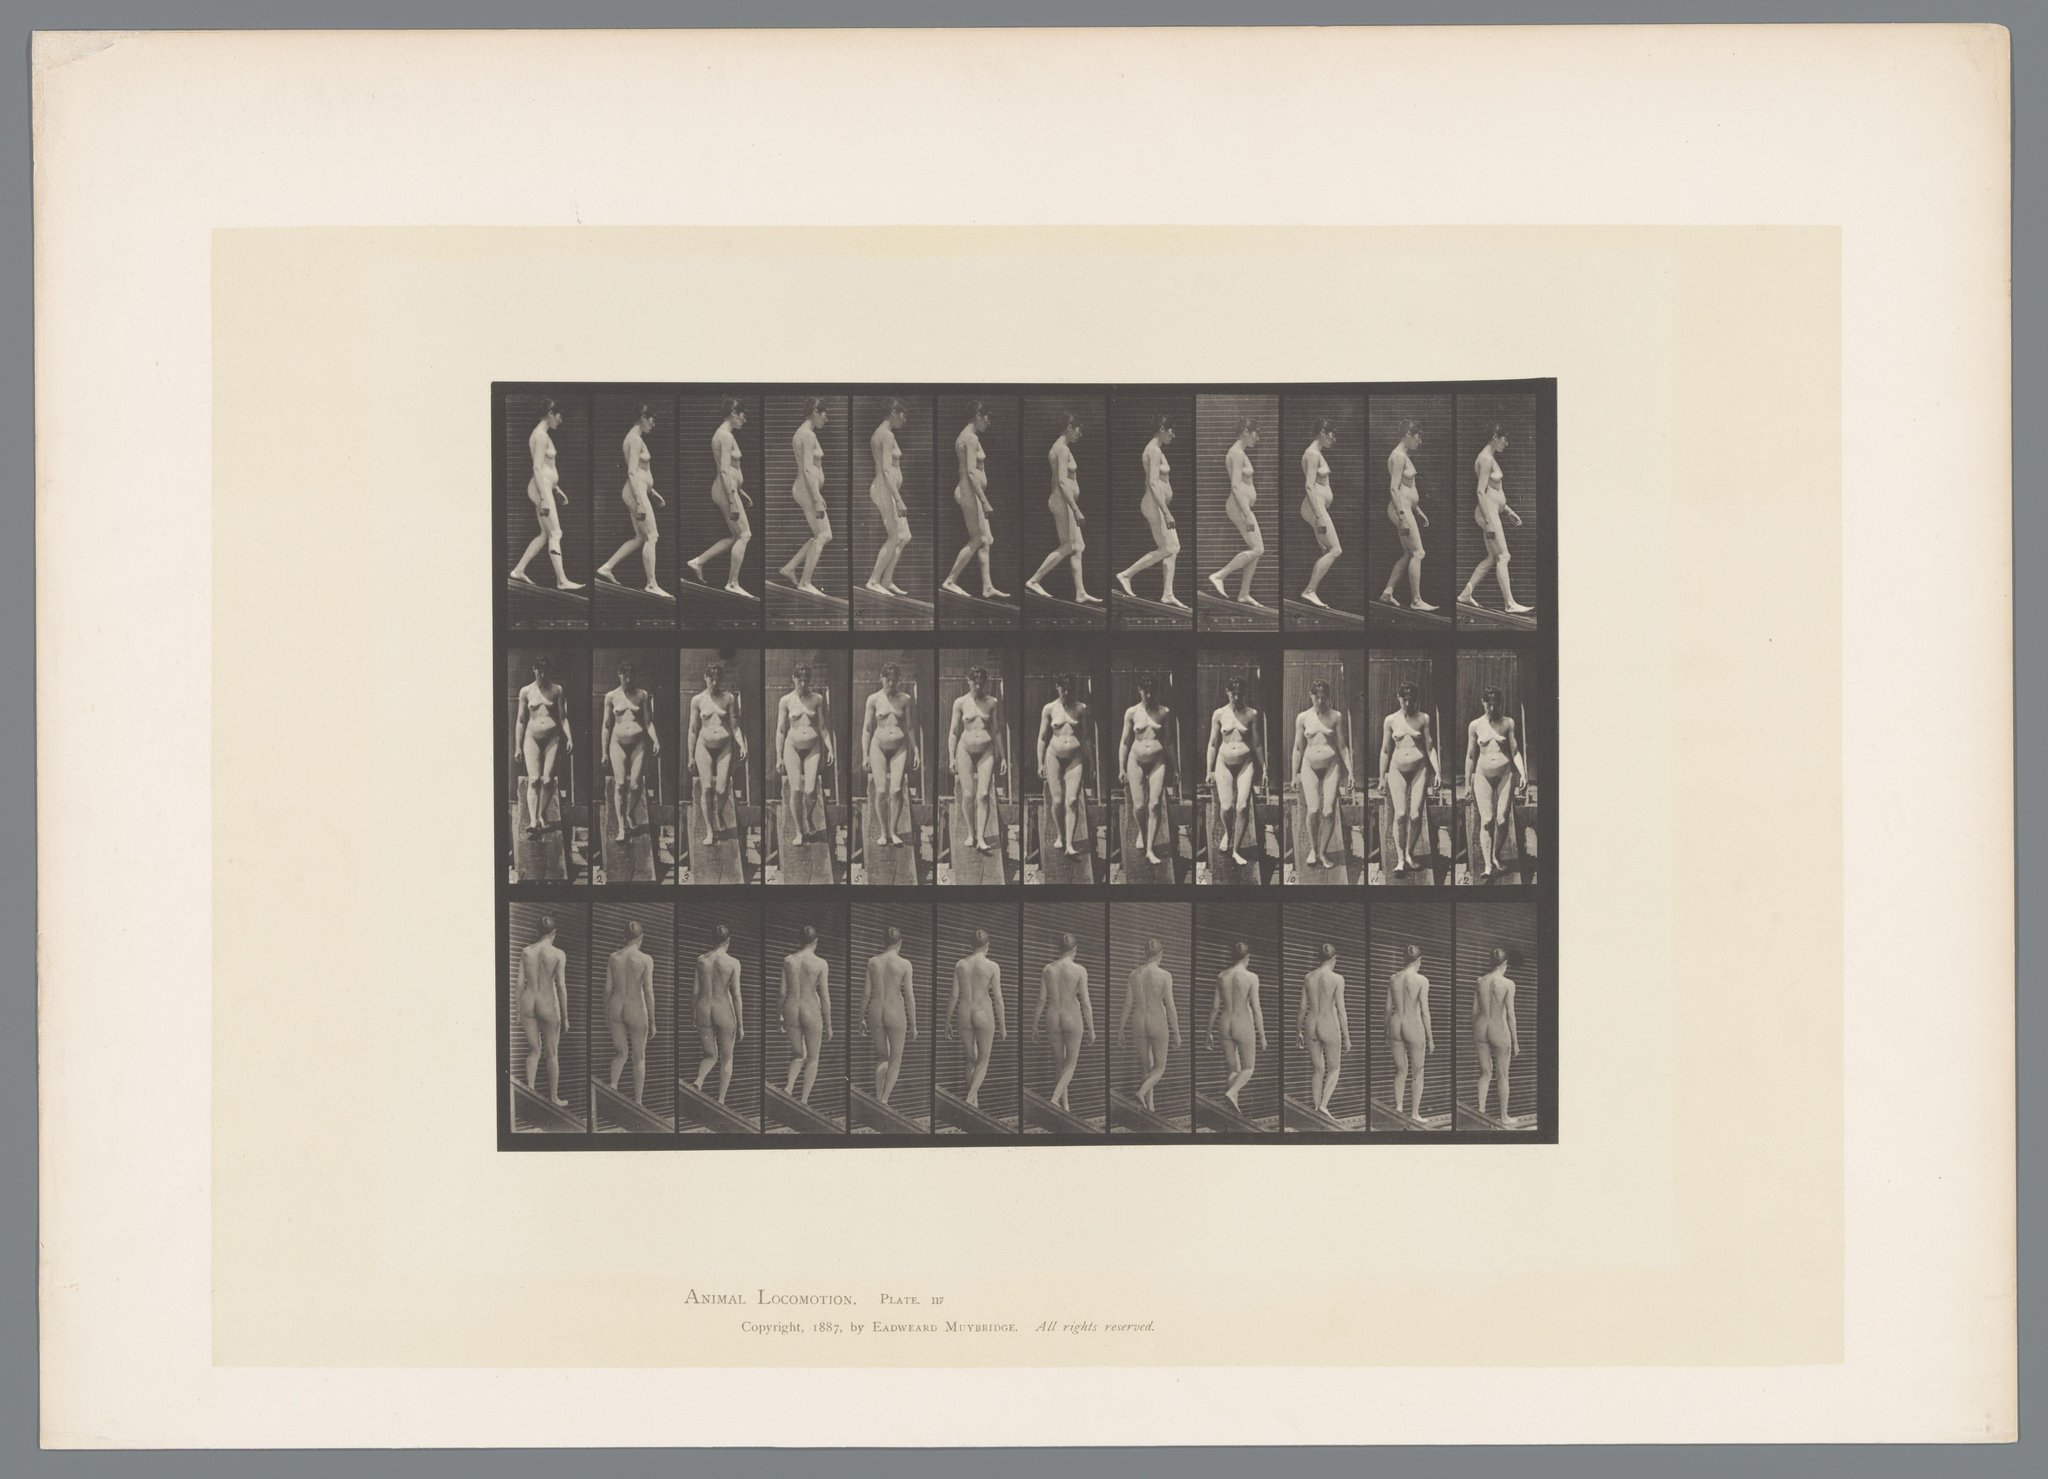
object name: photograph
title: Woman Walking Down an Incline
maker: eadweard muybridge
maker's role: fotograaf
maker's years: 1830-1904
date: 1885-1887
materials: cardboard, paper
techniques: photograph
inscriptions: number: ‘PLATE 117’, inscription: ‘EM 8013’, copyright notice: ‘COPYRIGHT, 1887, by EADWEARD MUYBRIDGE. All rights reserved / PLATE 117’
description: Uit Animal Locomotion, pl. 117 Philadelphia 1887.